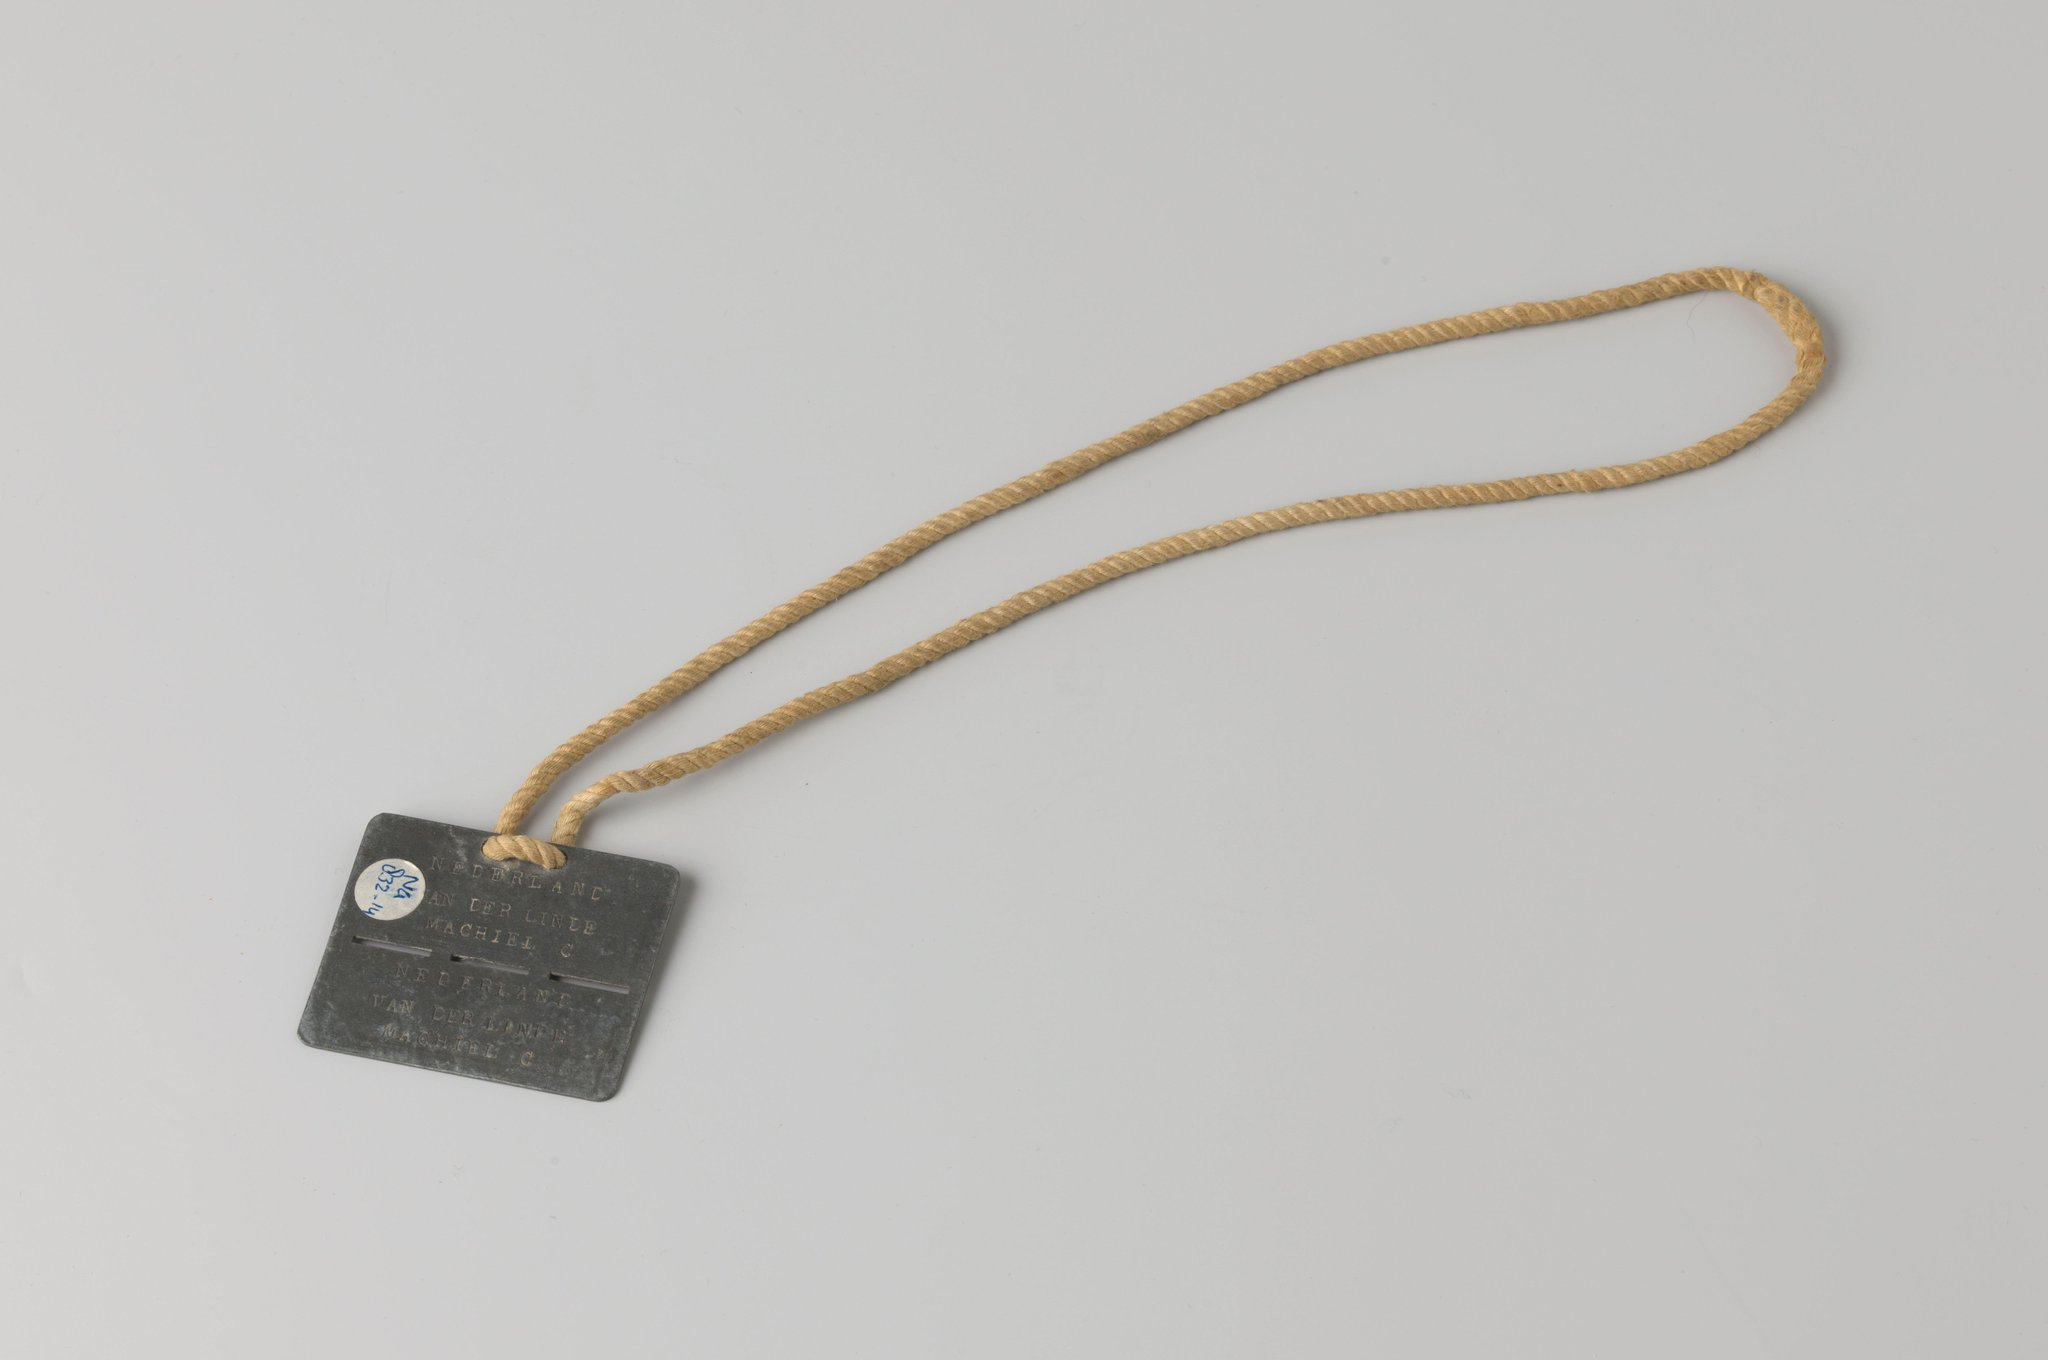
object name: identiteitsplaat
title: Identiteitsplaat Nederlandse Leger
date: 1916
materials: metal, fiber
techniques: braiding, striking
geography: netherlands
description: Rechthoekig metalen plaatje, in de lengte geperforeerd. Aan boven- en onderzijde dezelfde opschriften. Middenboven 2 ronde gaten waardoor een lichtkleurig touwtje waarvan de uiteinden in elkaar gevlochten zijn. Opschrift voorzijde: (2x): NEDERLAND / VAN DER LINDE / MACHIEL C. Opschrift keerzijde (2x): AMSTERDAM 5-5-1900 RK / RJ V STAF 37.